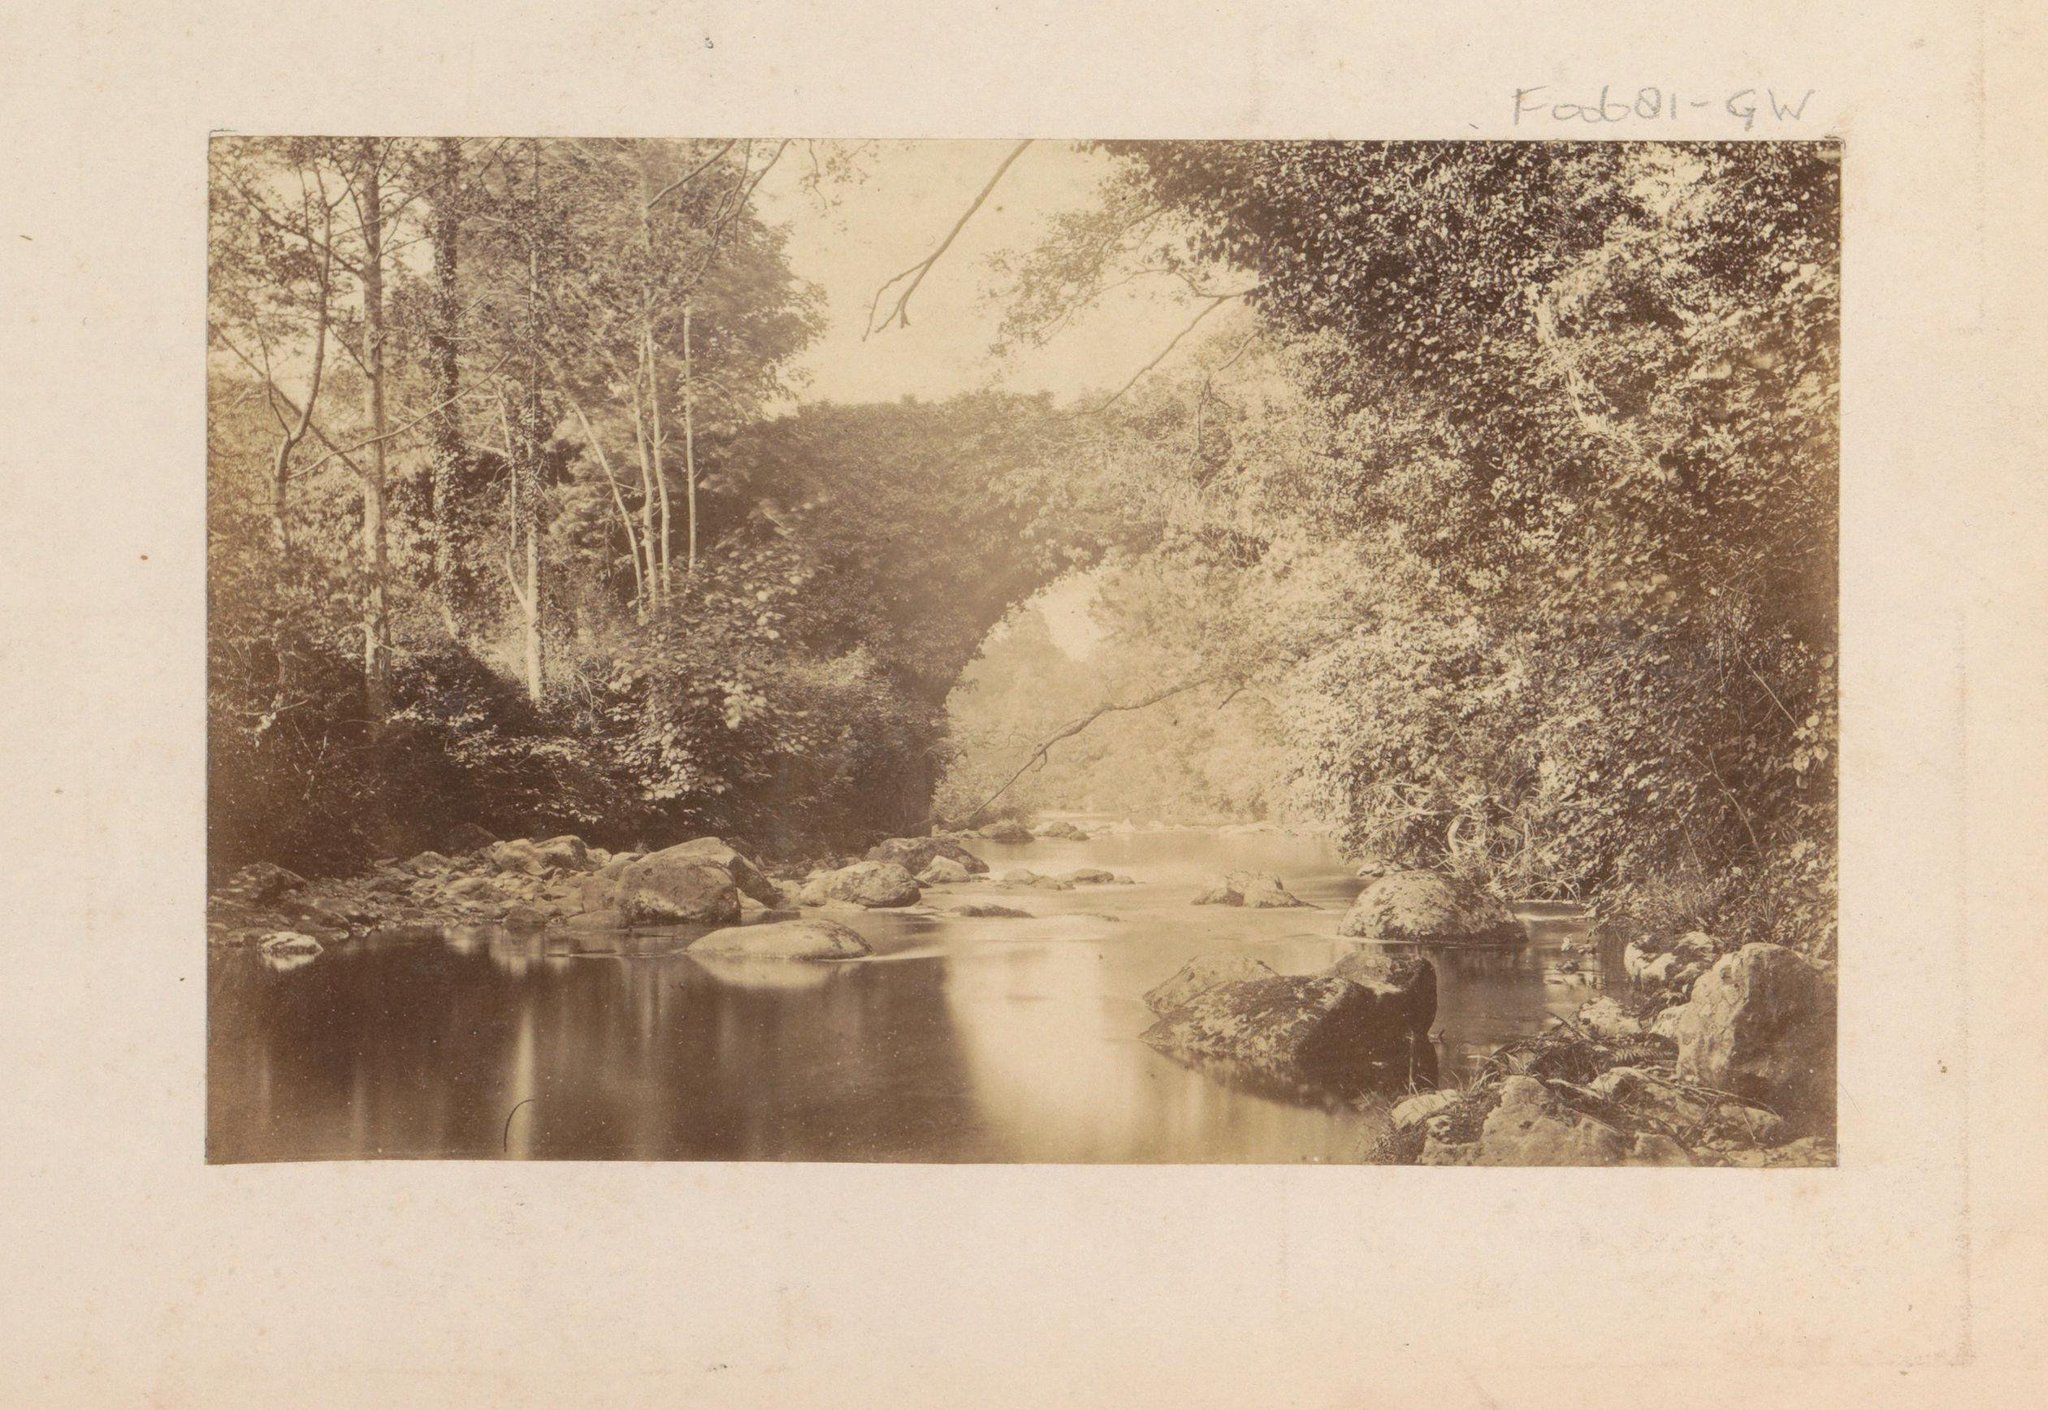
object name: photograph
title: Rivierlandschap met overwoekerde brug in Engeland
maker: Anonymous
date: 1850-1870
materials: paper, photographic support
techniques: albumen print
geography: england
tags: bridge, landscapes with waters, waterscapes, seascapes (in the temperate zone) (+ landscape with figures, staffage), england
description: Onderdeel van Album met foto's van bezienswaardigheden en landschappen in Engeland en van kunst.